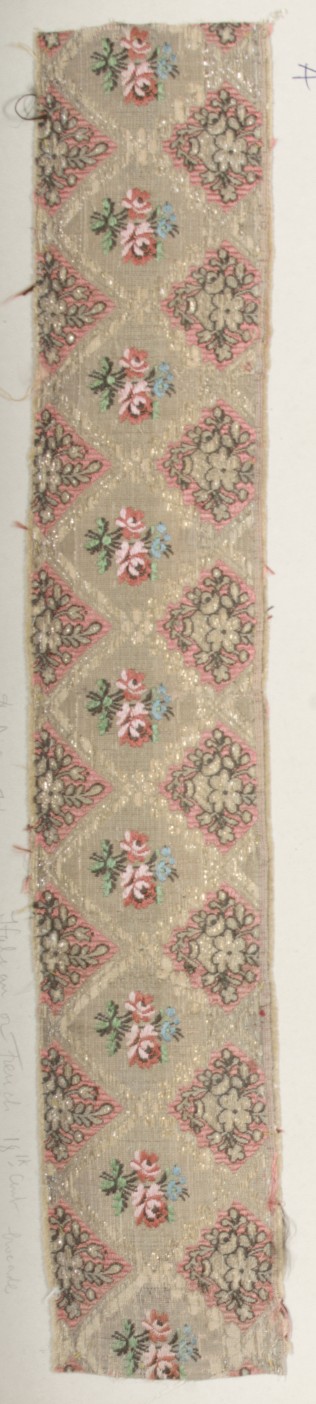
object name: fragment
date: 1701-1800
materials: metal thread, silk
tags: flowers